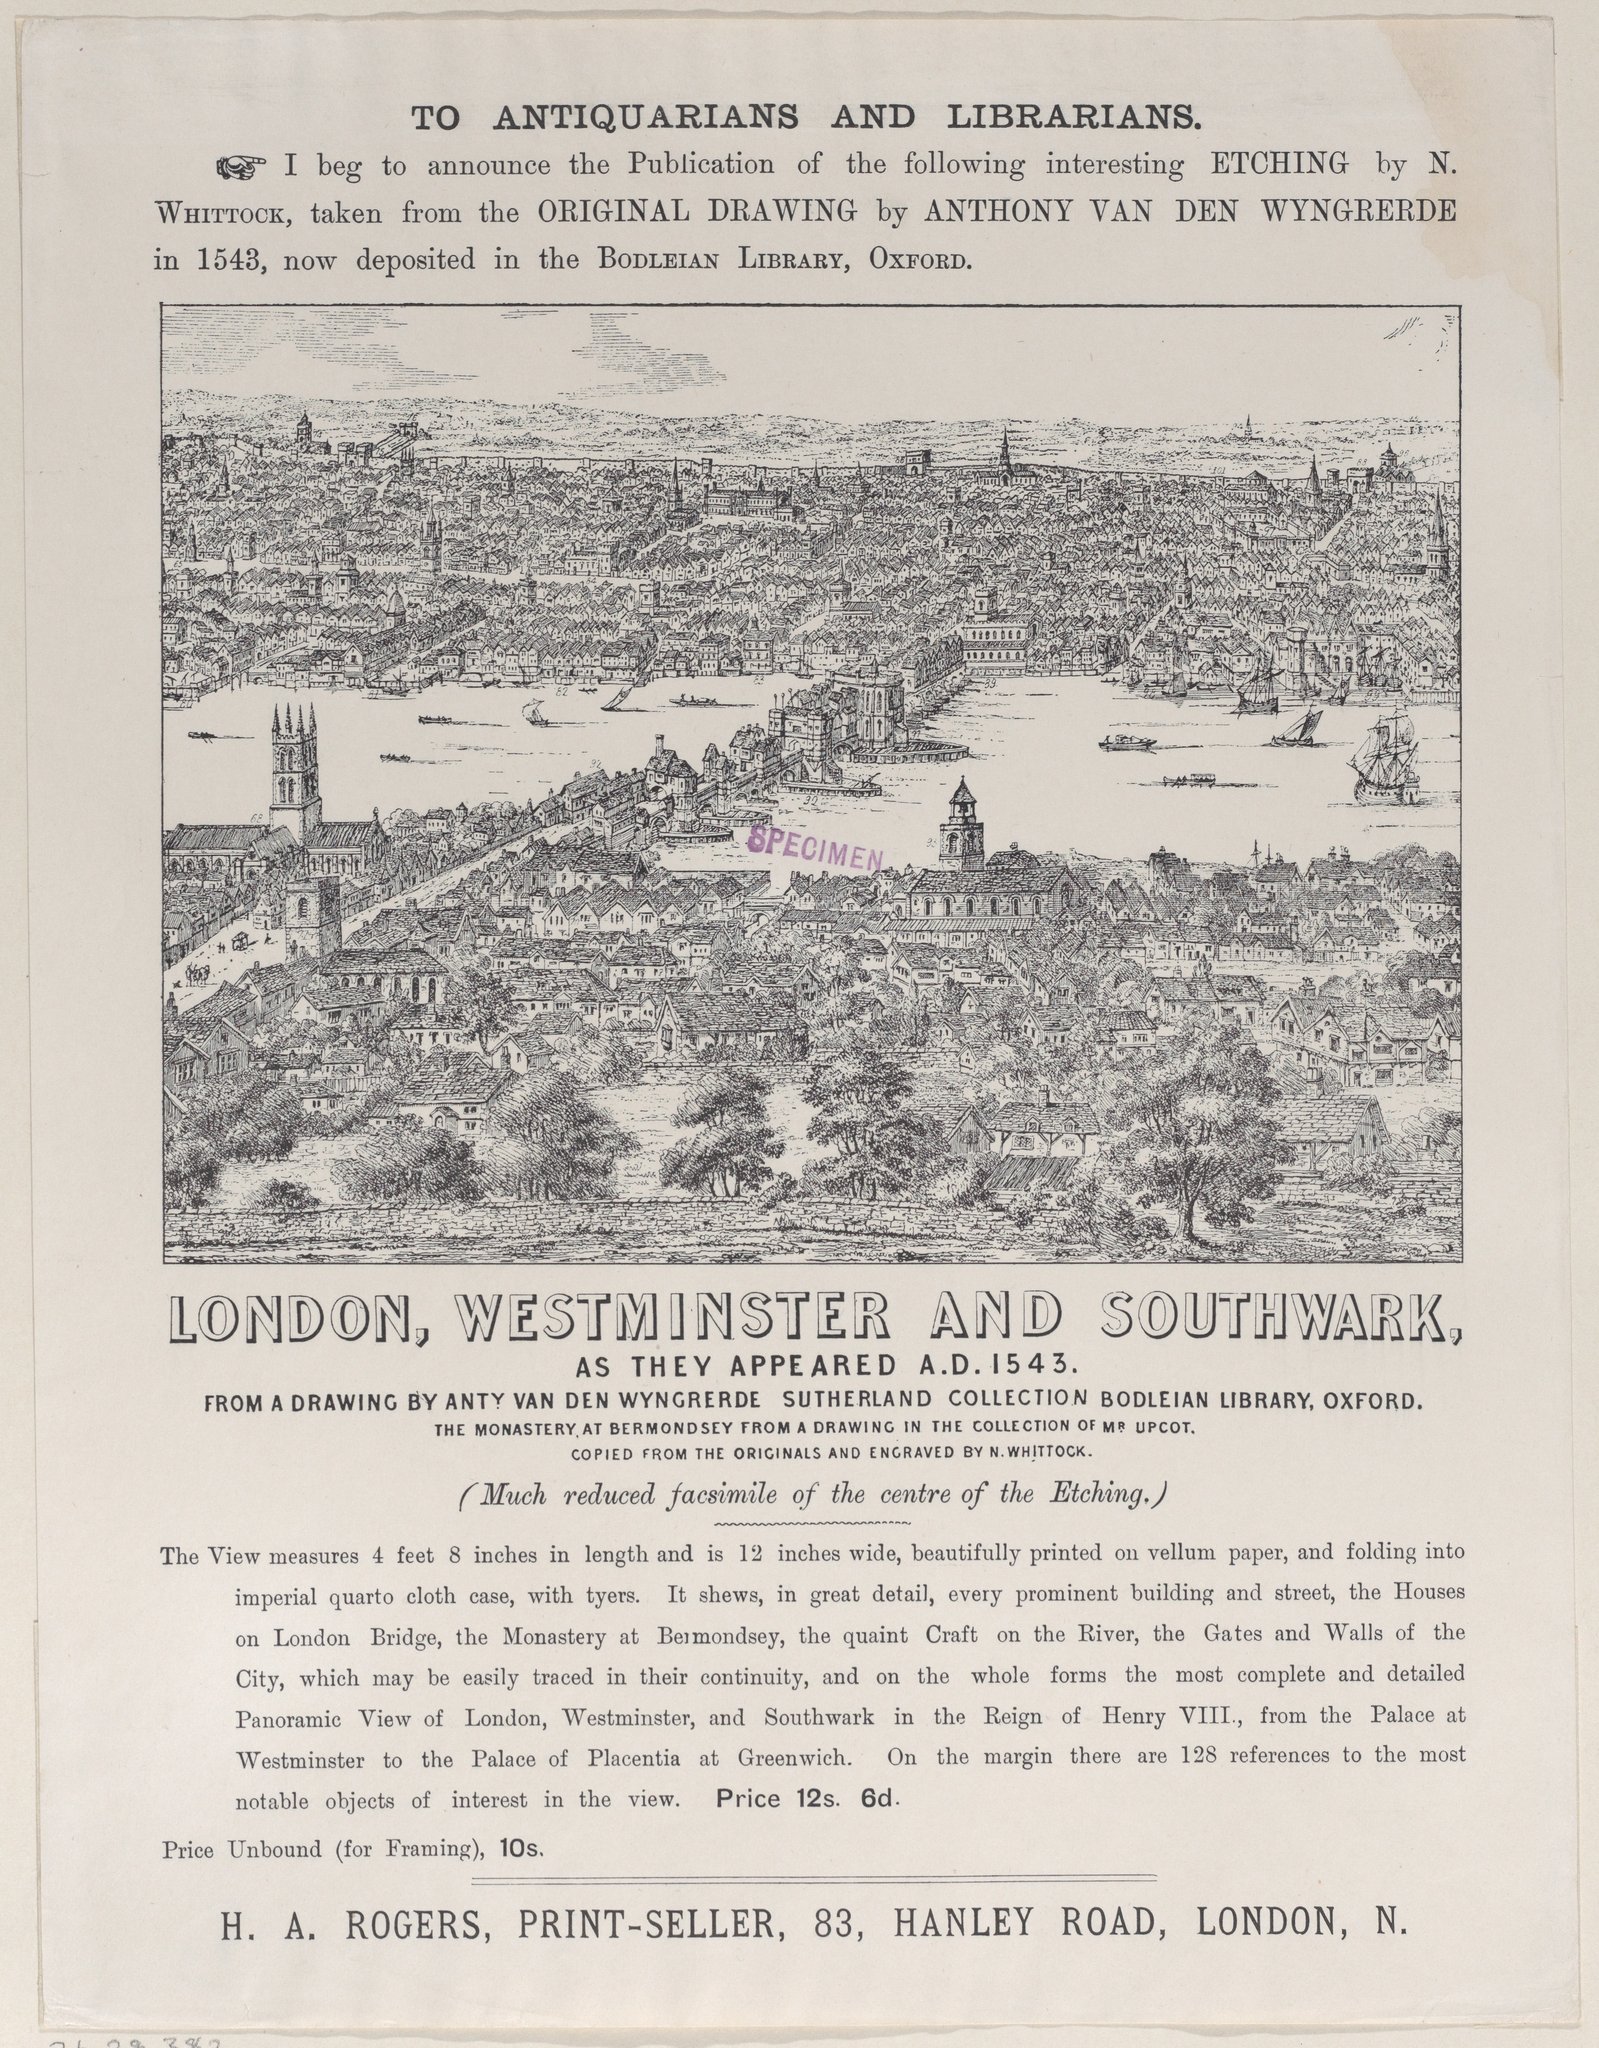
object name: print, trade card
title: Announcement by H. A. Rogers of the publication of an etching showing London, Westminster and Southwark as they appeared A.D. 1543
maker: nathaniel whittock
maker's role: artist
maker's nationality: british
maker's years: 1791-1860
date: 1801-1900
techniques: engraving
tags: london